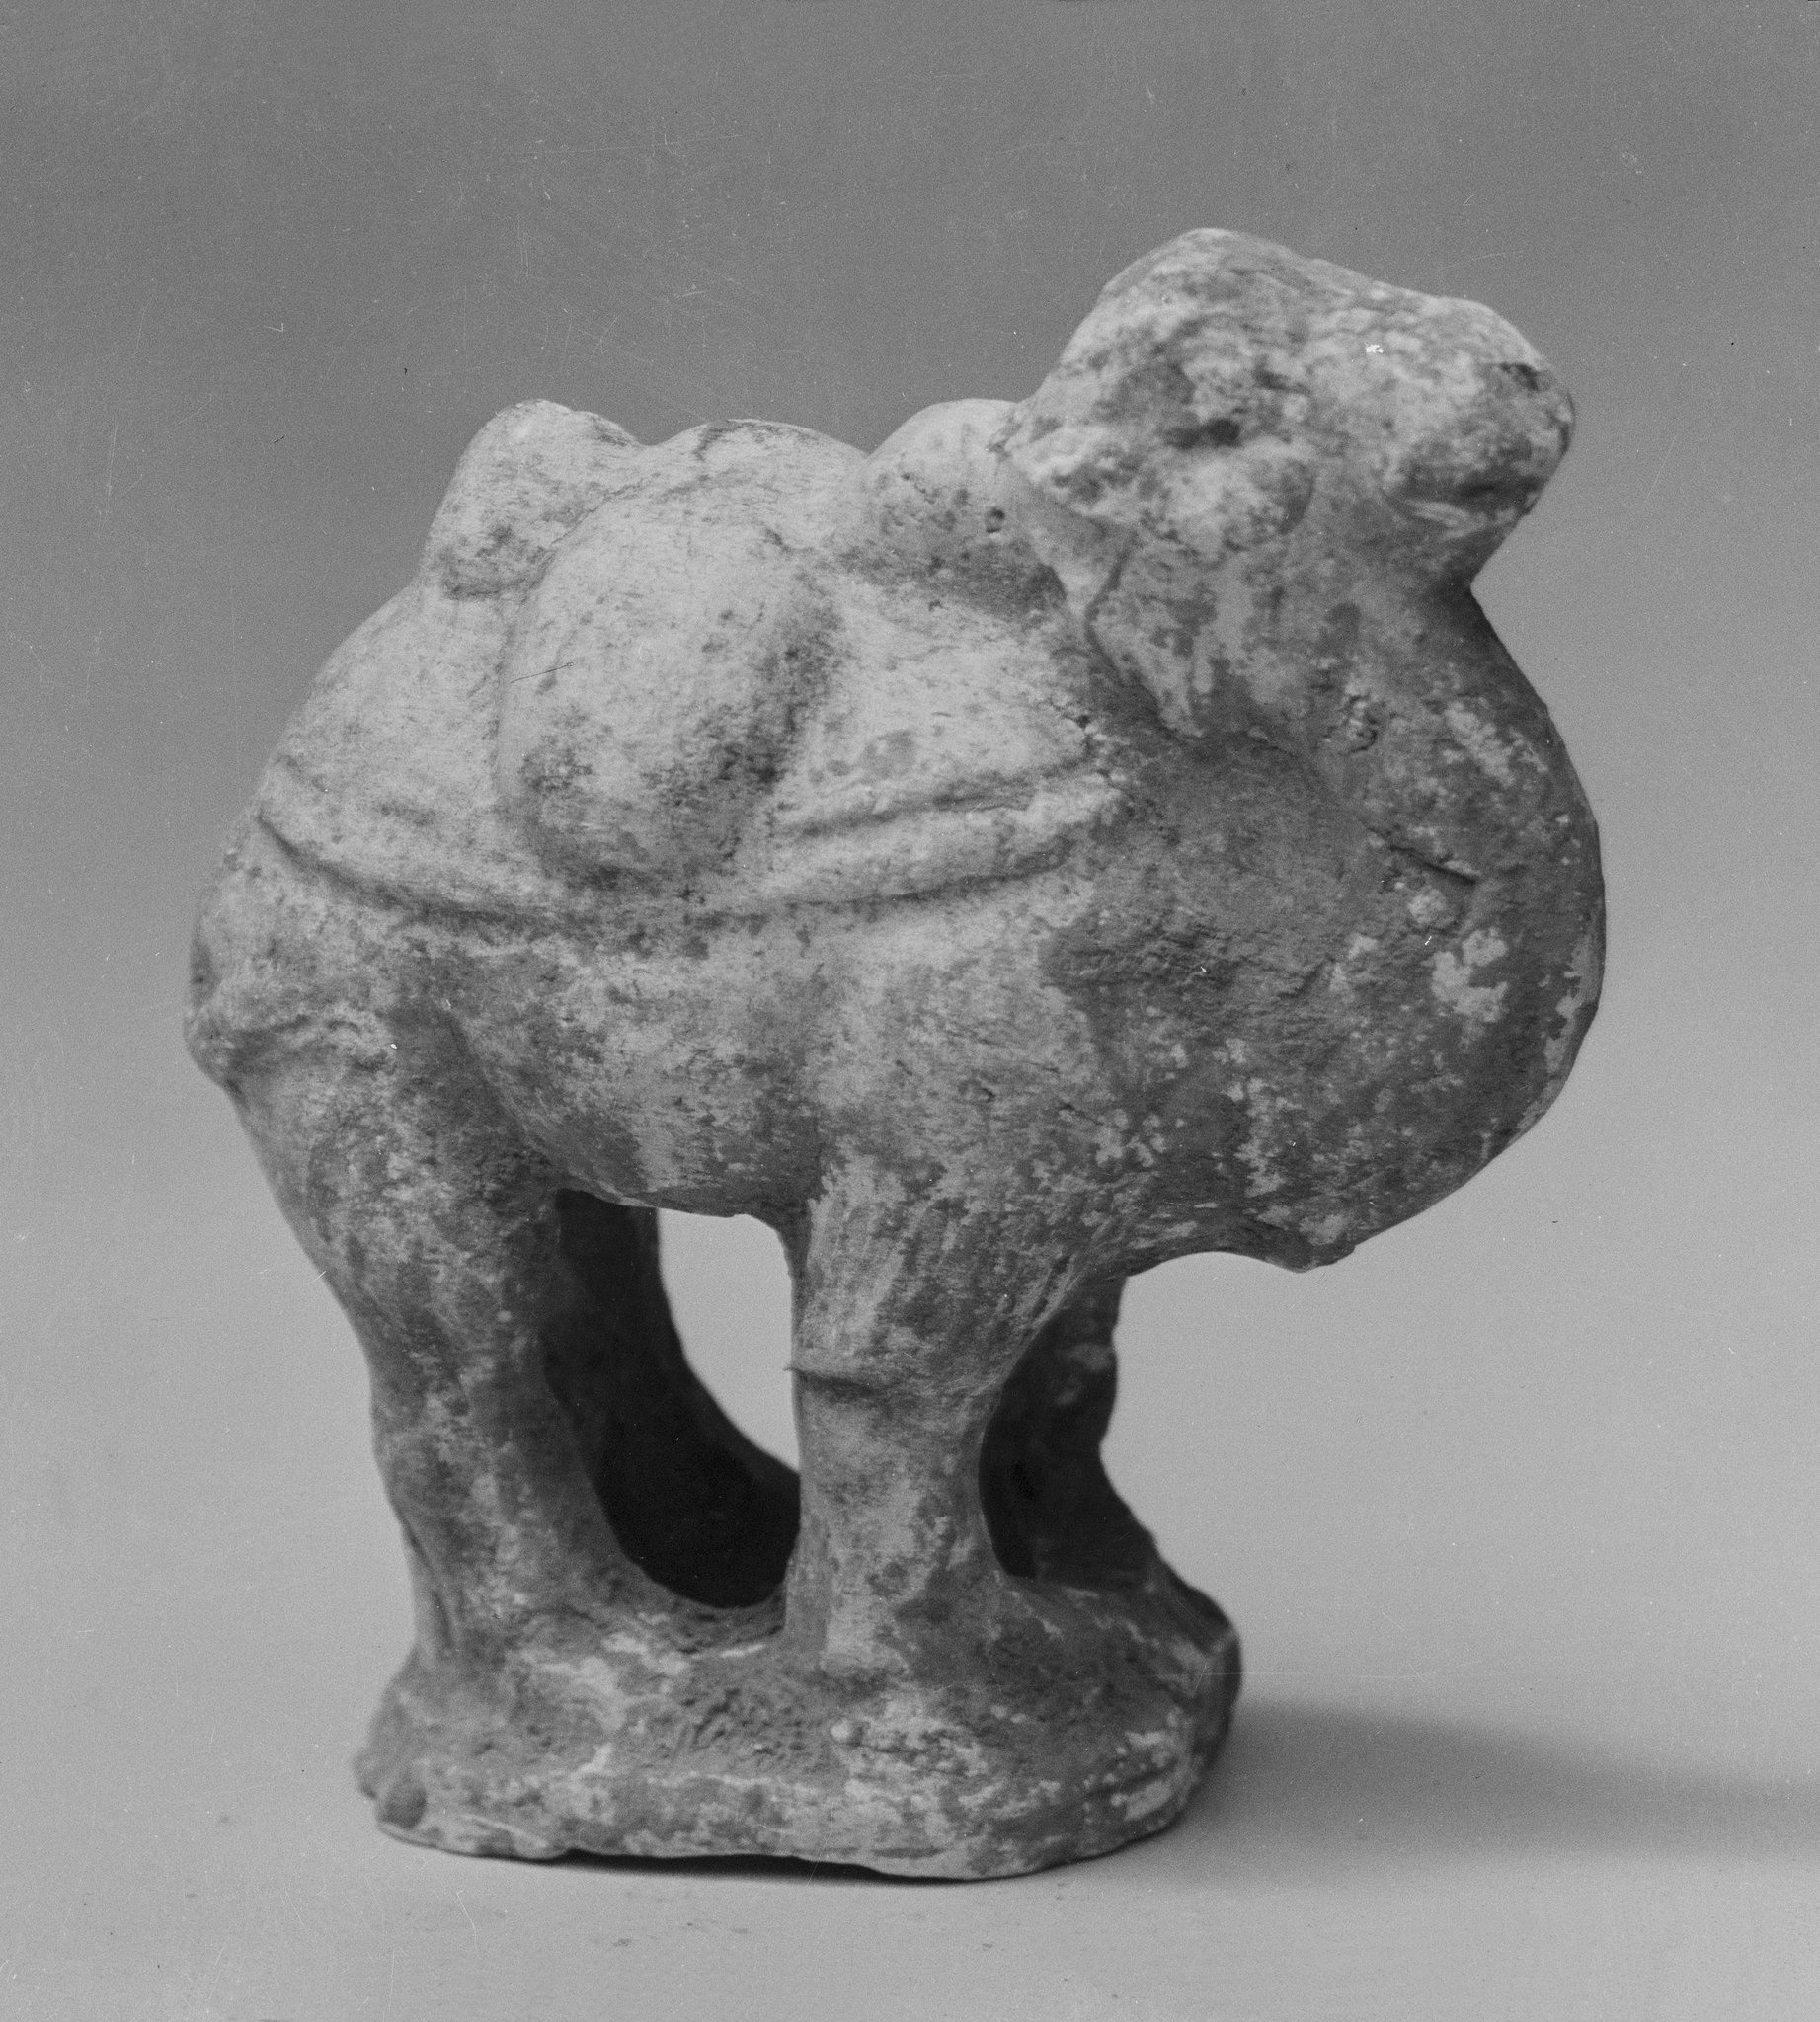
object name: tomb figure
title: Camel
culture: chinese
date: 601-800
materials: earthenware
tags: camels